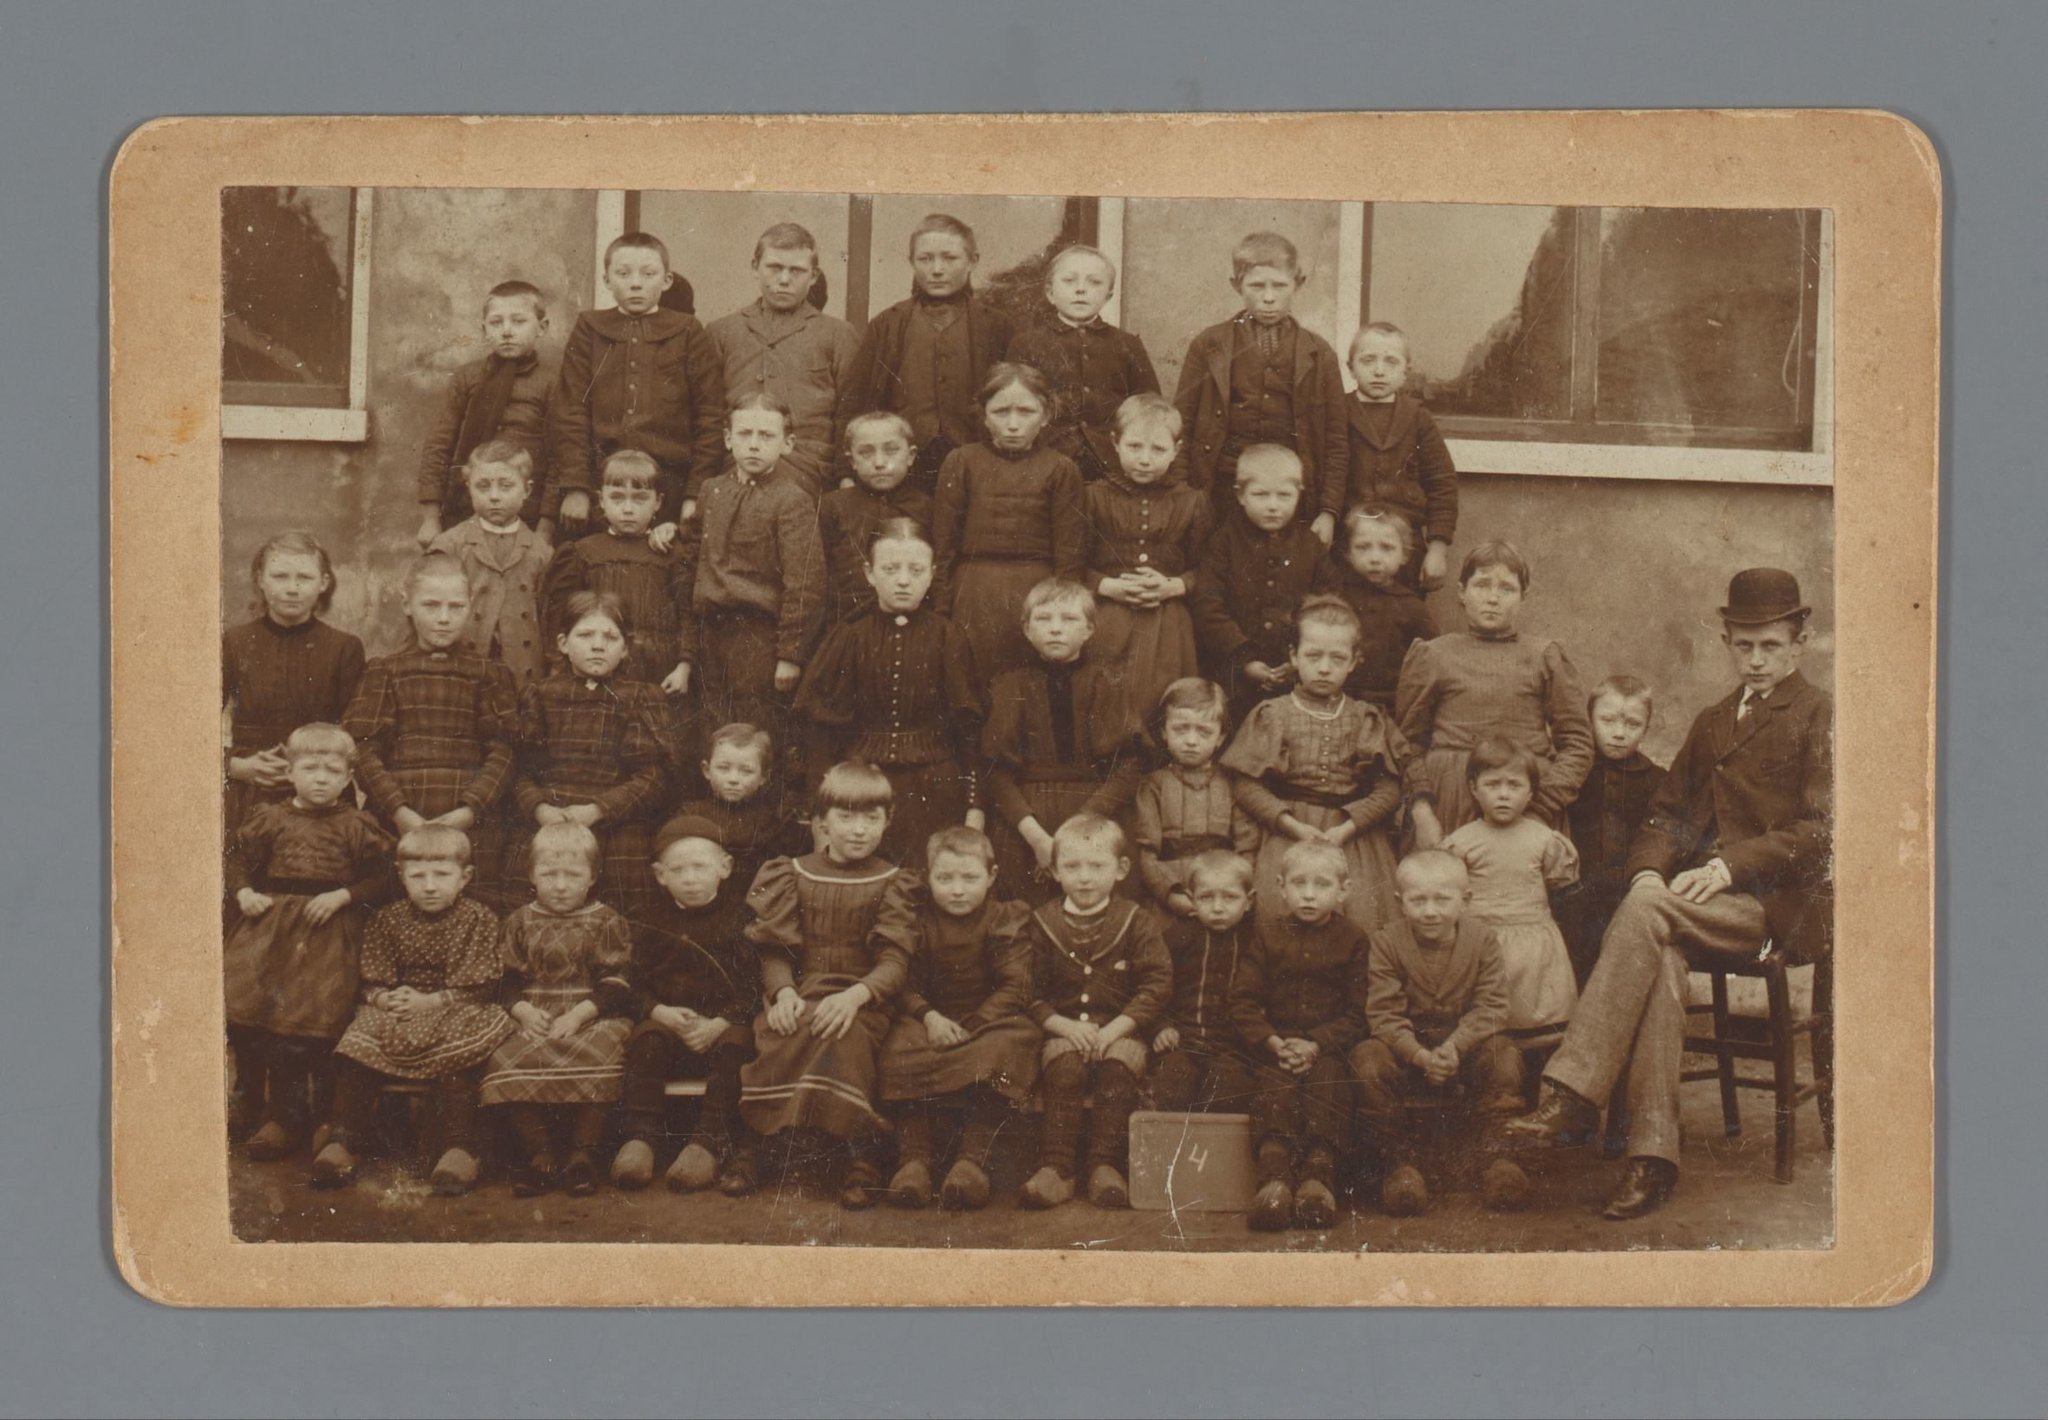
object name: cabinet photograph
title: Groepsportret van een schoolklas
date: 1900-1915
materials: cardboard, photographic support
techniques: gelatin silver print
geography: groningen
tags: child, anonymous historical persons portrayed in a group, in a group-portrait